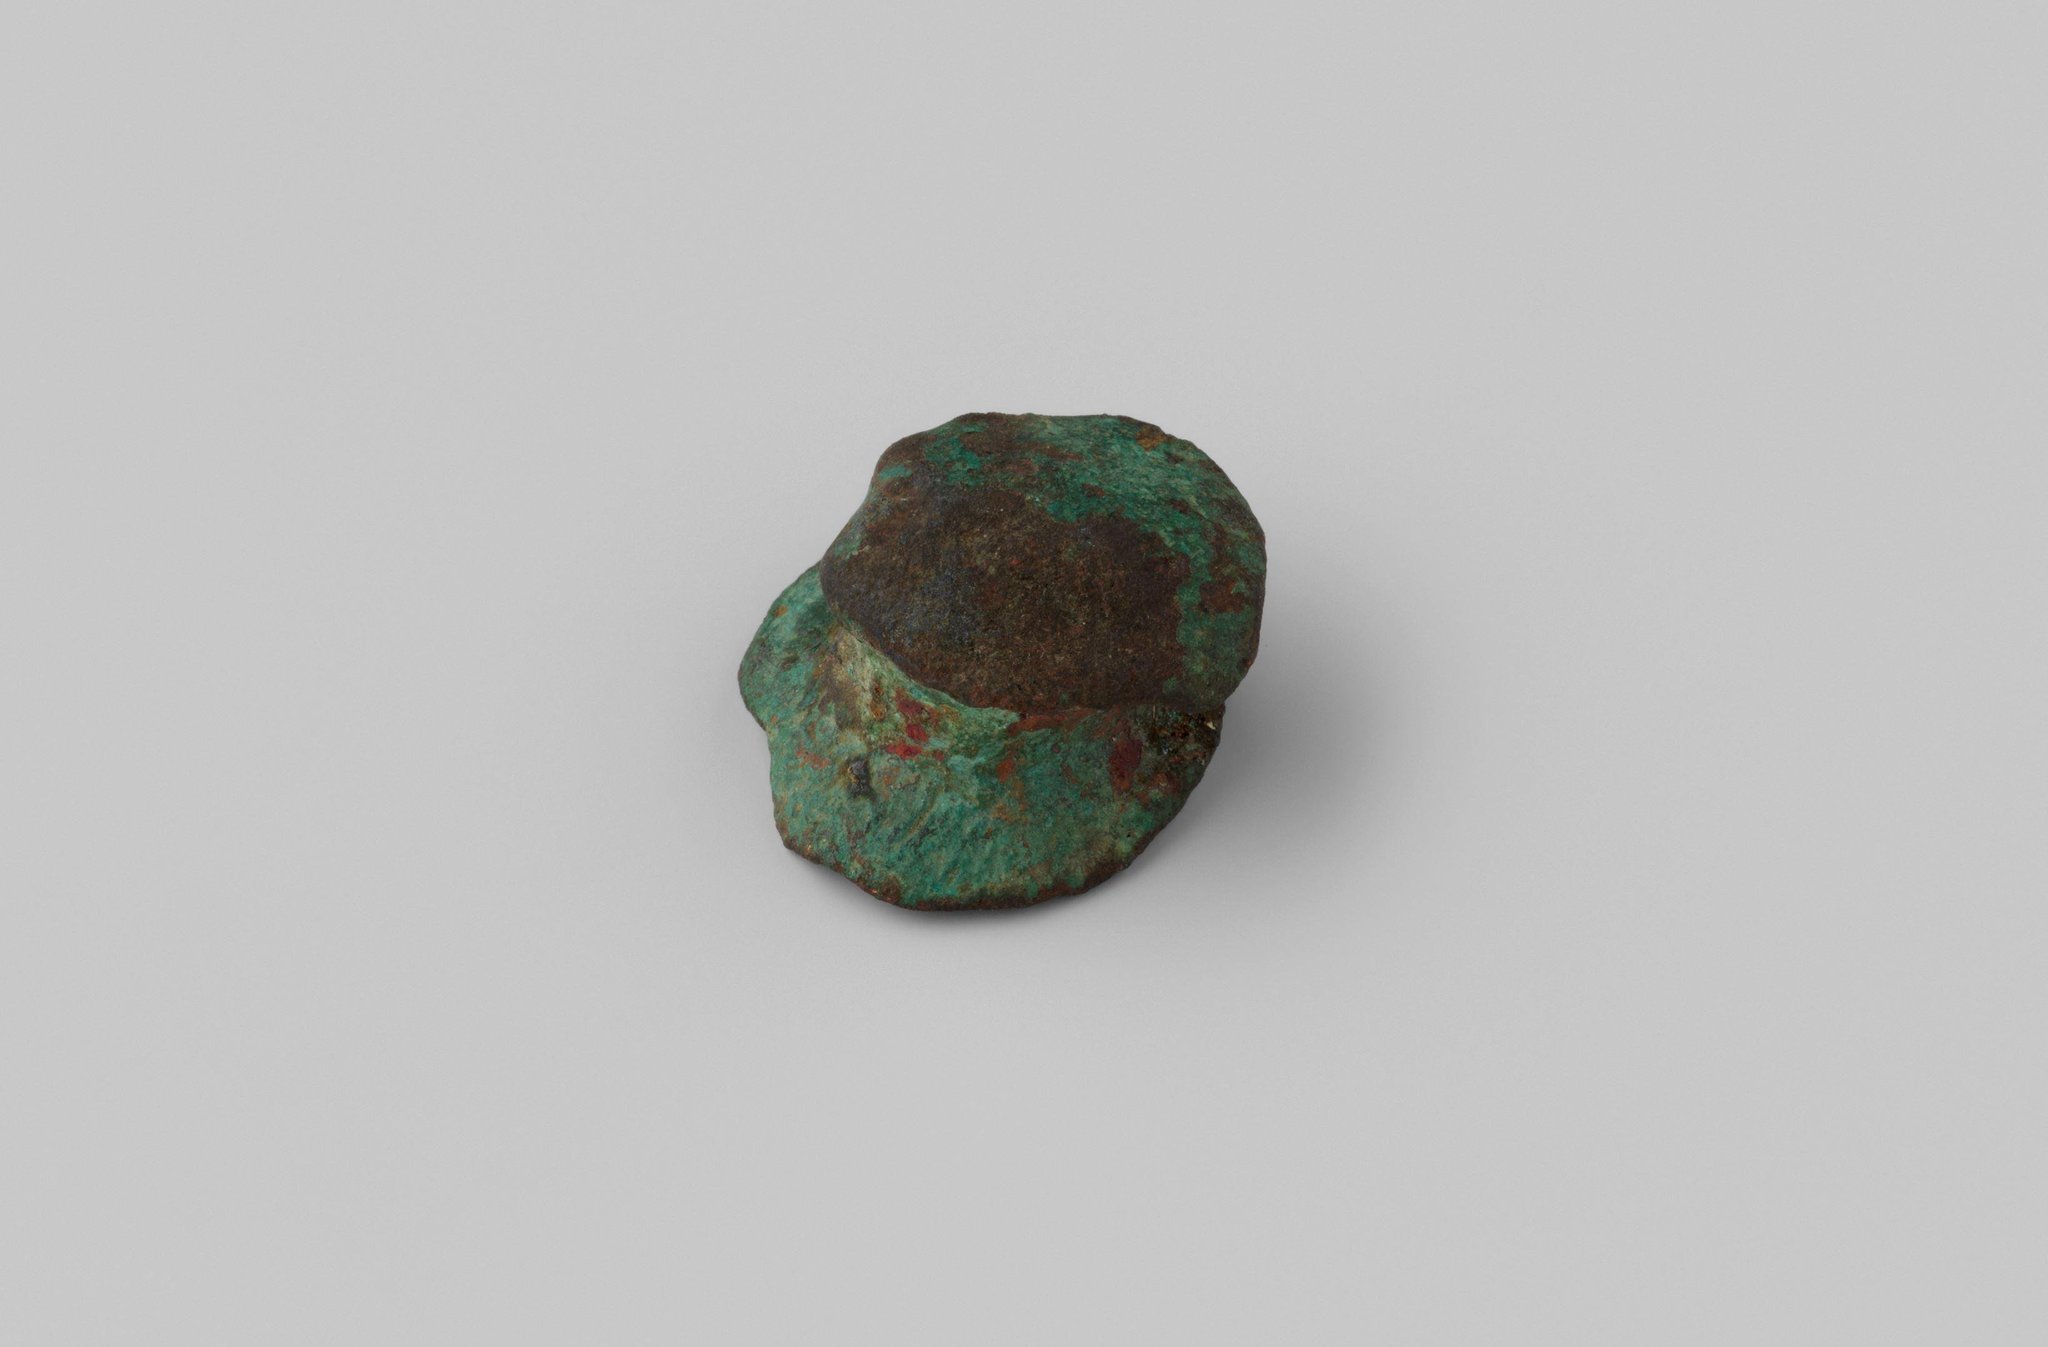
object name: knife handle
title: Messenheft uit het wrak van de Oost-Indiëvaarder Hollandia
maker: Anonymous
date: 1700-1743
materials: copper, wood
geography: netherlands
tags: verenigde oostindische compagnie, hollandia (schip), annet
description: Knife, handle, cylindrical: tapering; id. NG 1979-403H, ferrule, id. NG 1980-27H426.